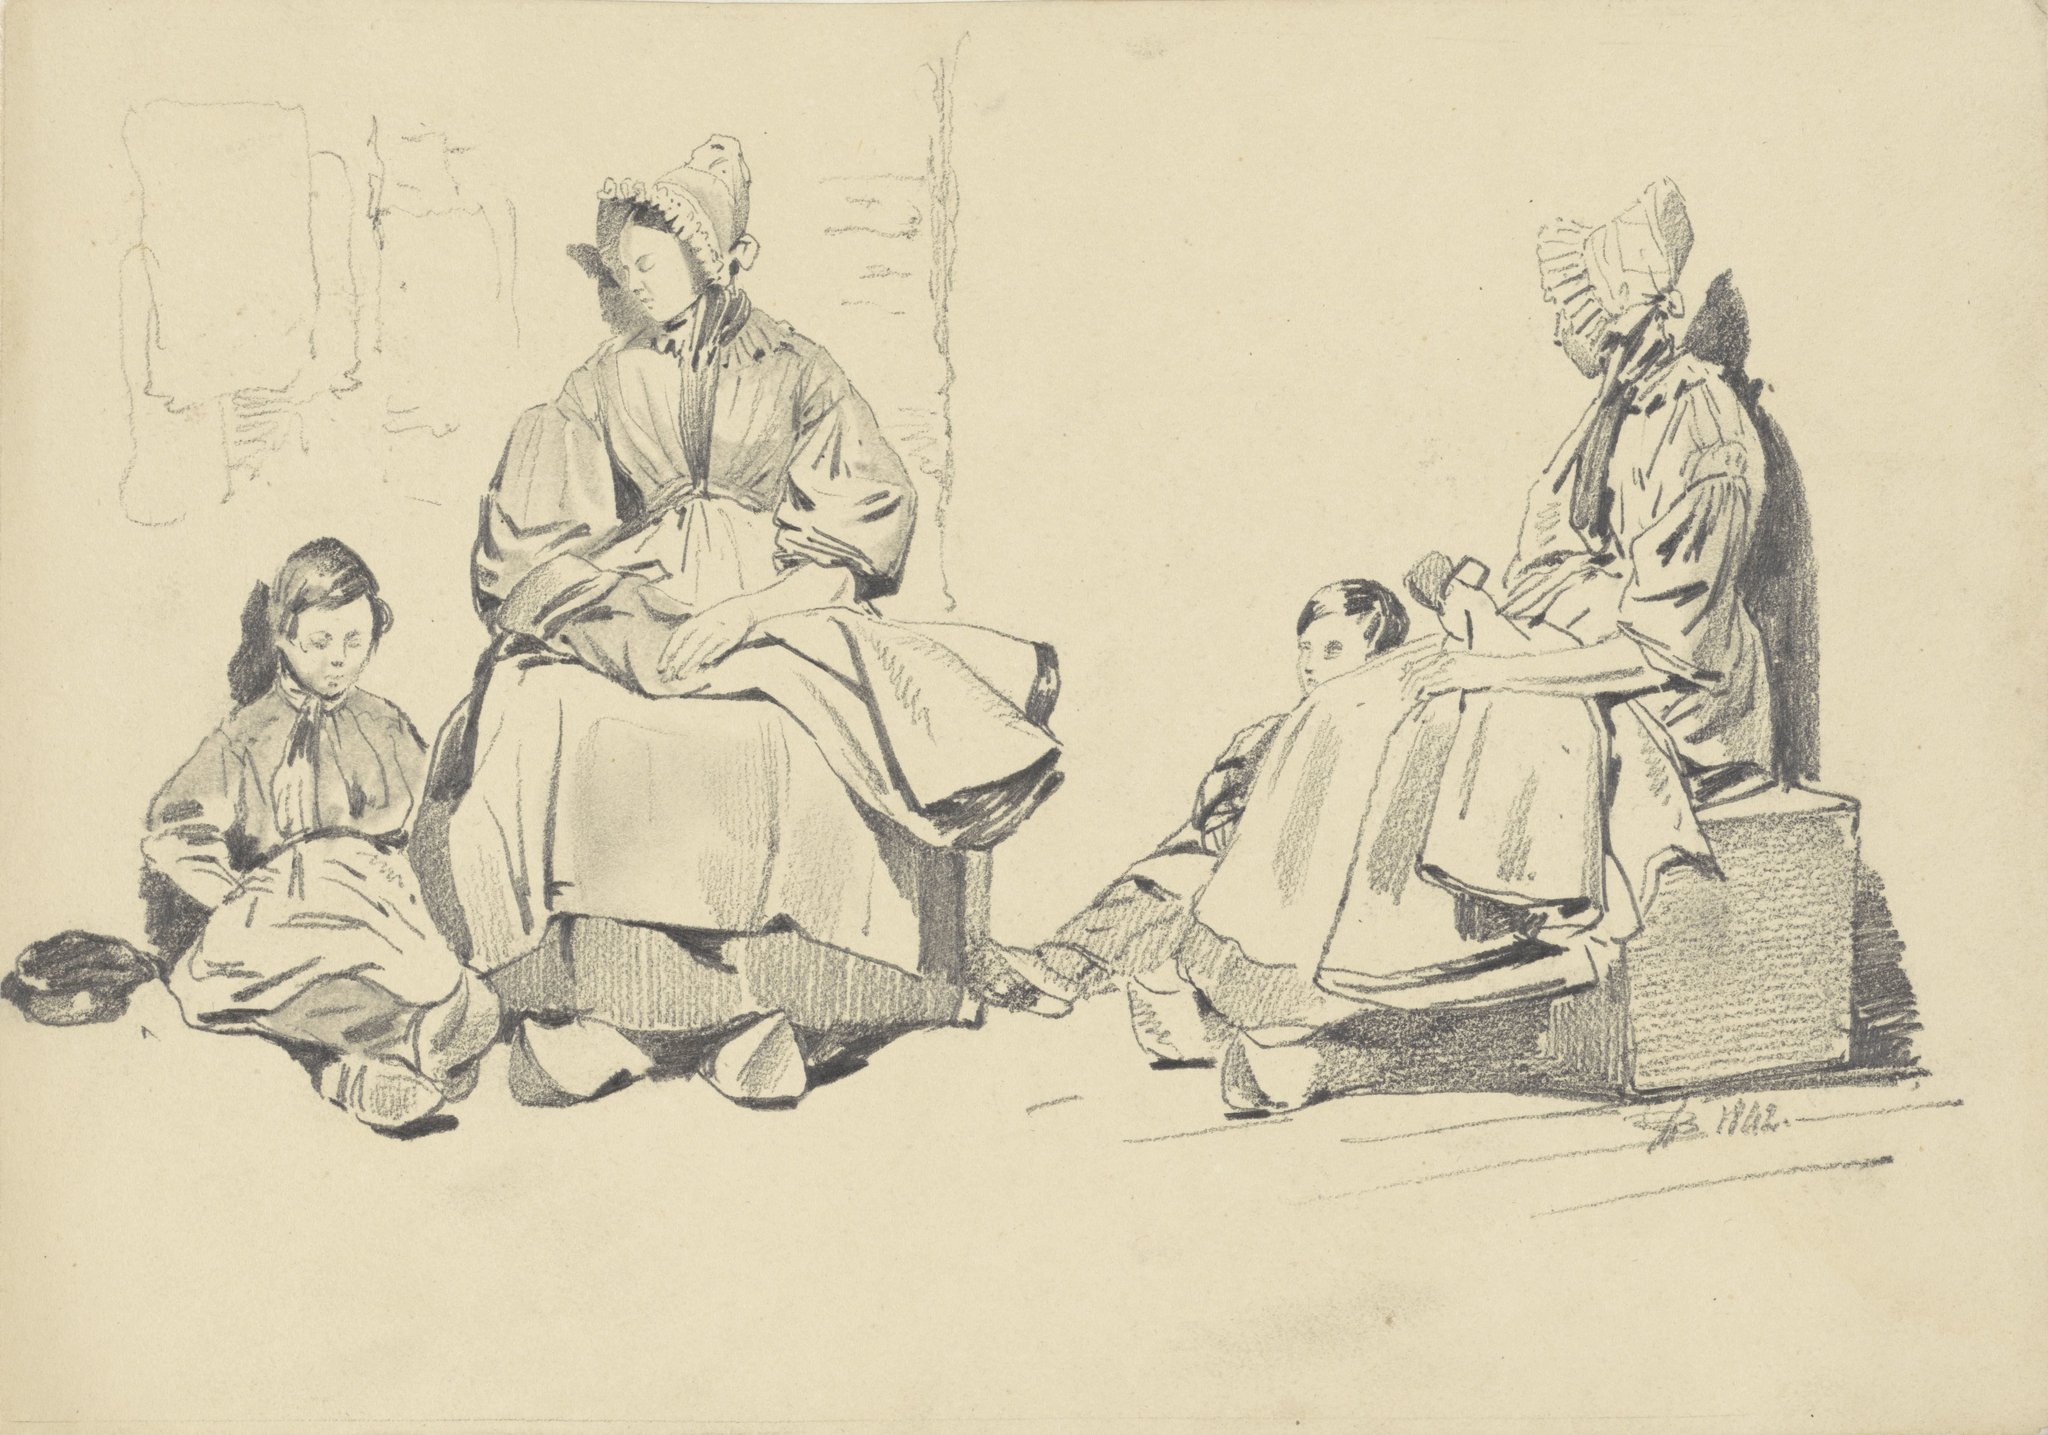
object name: drawing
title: Twee studies van een zittende vrouw en jongetje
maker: pieter van loon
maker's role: draughtsman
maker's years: 1801-1873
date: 1842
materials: paper, pencil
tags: mother and baby or young child